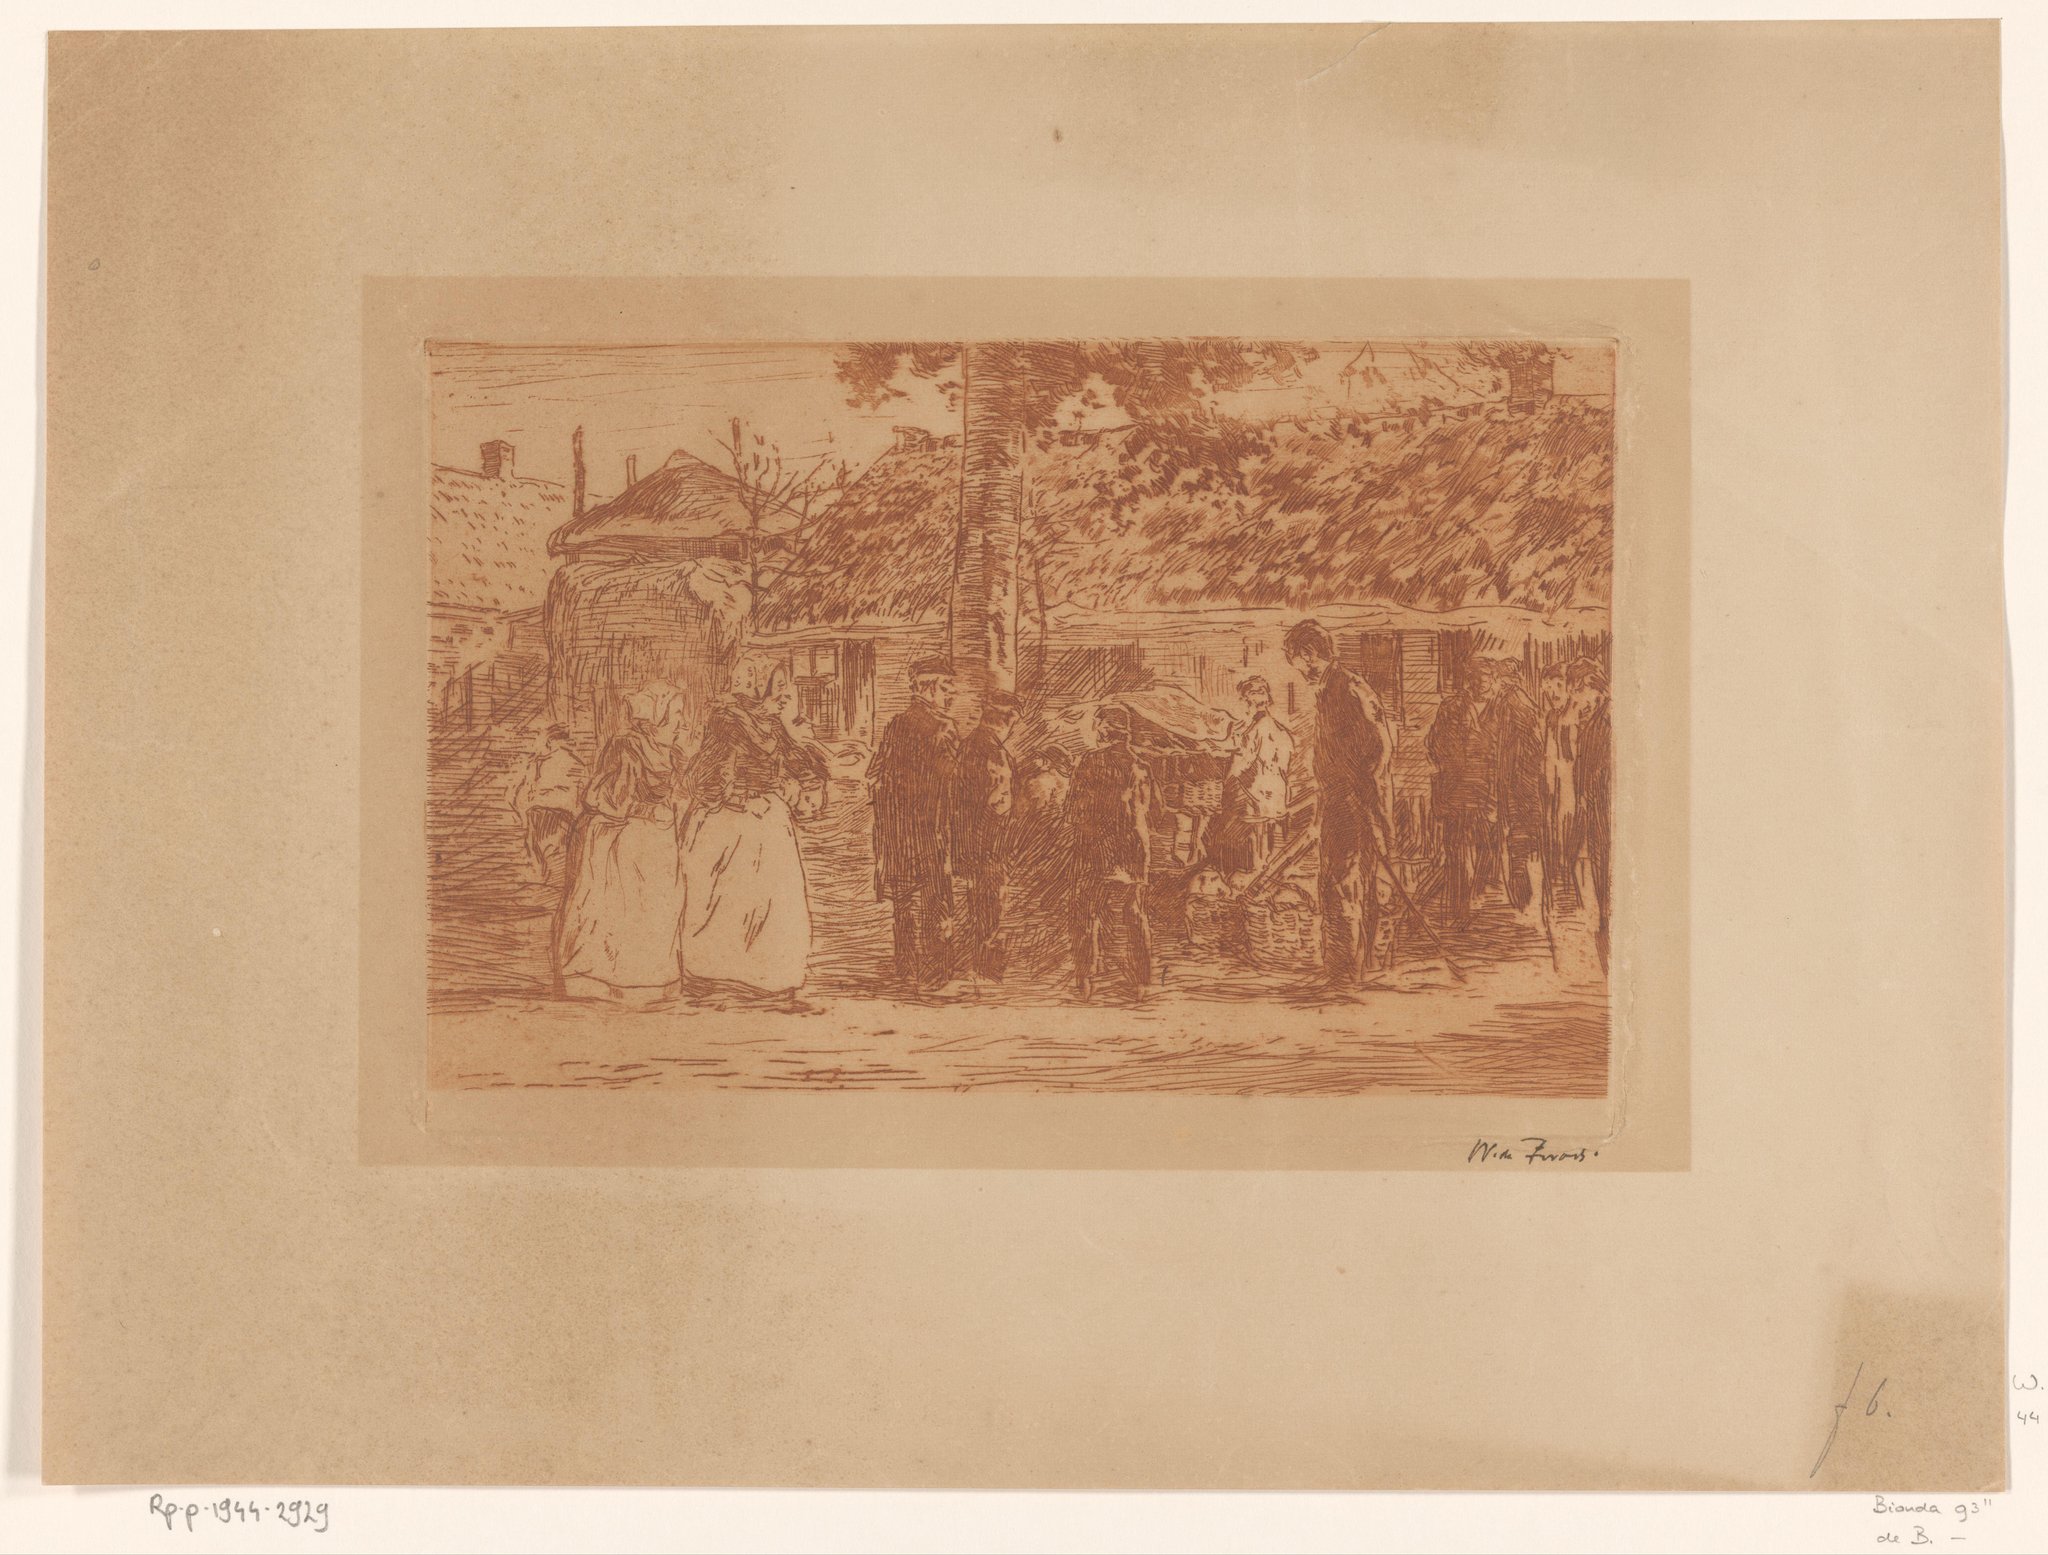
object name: print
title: Boeren op een dorpsmarkt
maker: willem de zwart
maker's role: draughtsman, painter, print maker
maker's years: 1862-1931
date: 1897-1898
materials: paper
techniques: drypoint, etching, intaglio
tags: village, market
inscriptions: collector's mark: Lugt 2228, collector's mark: Lugt 2760